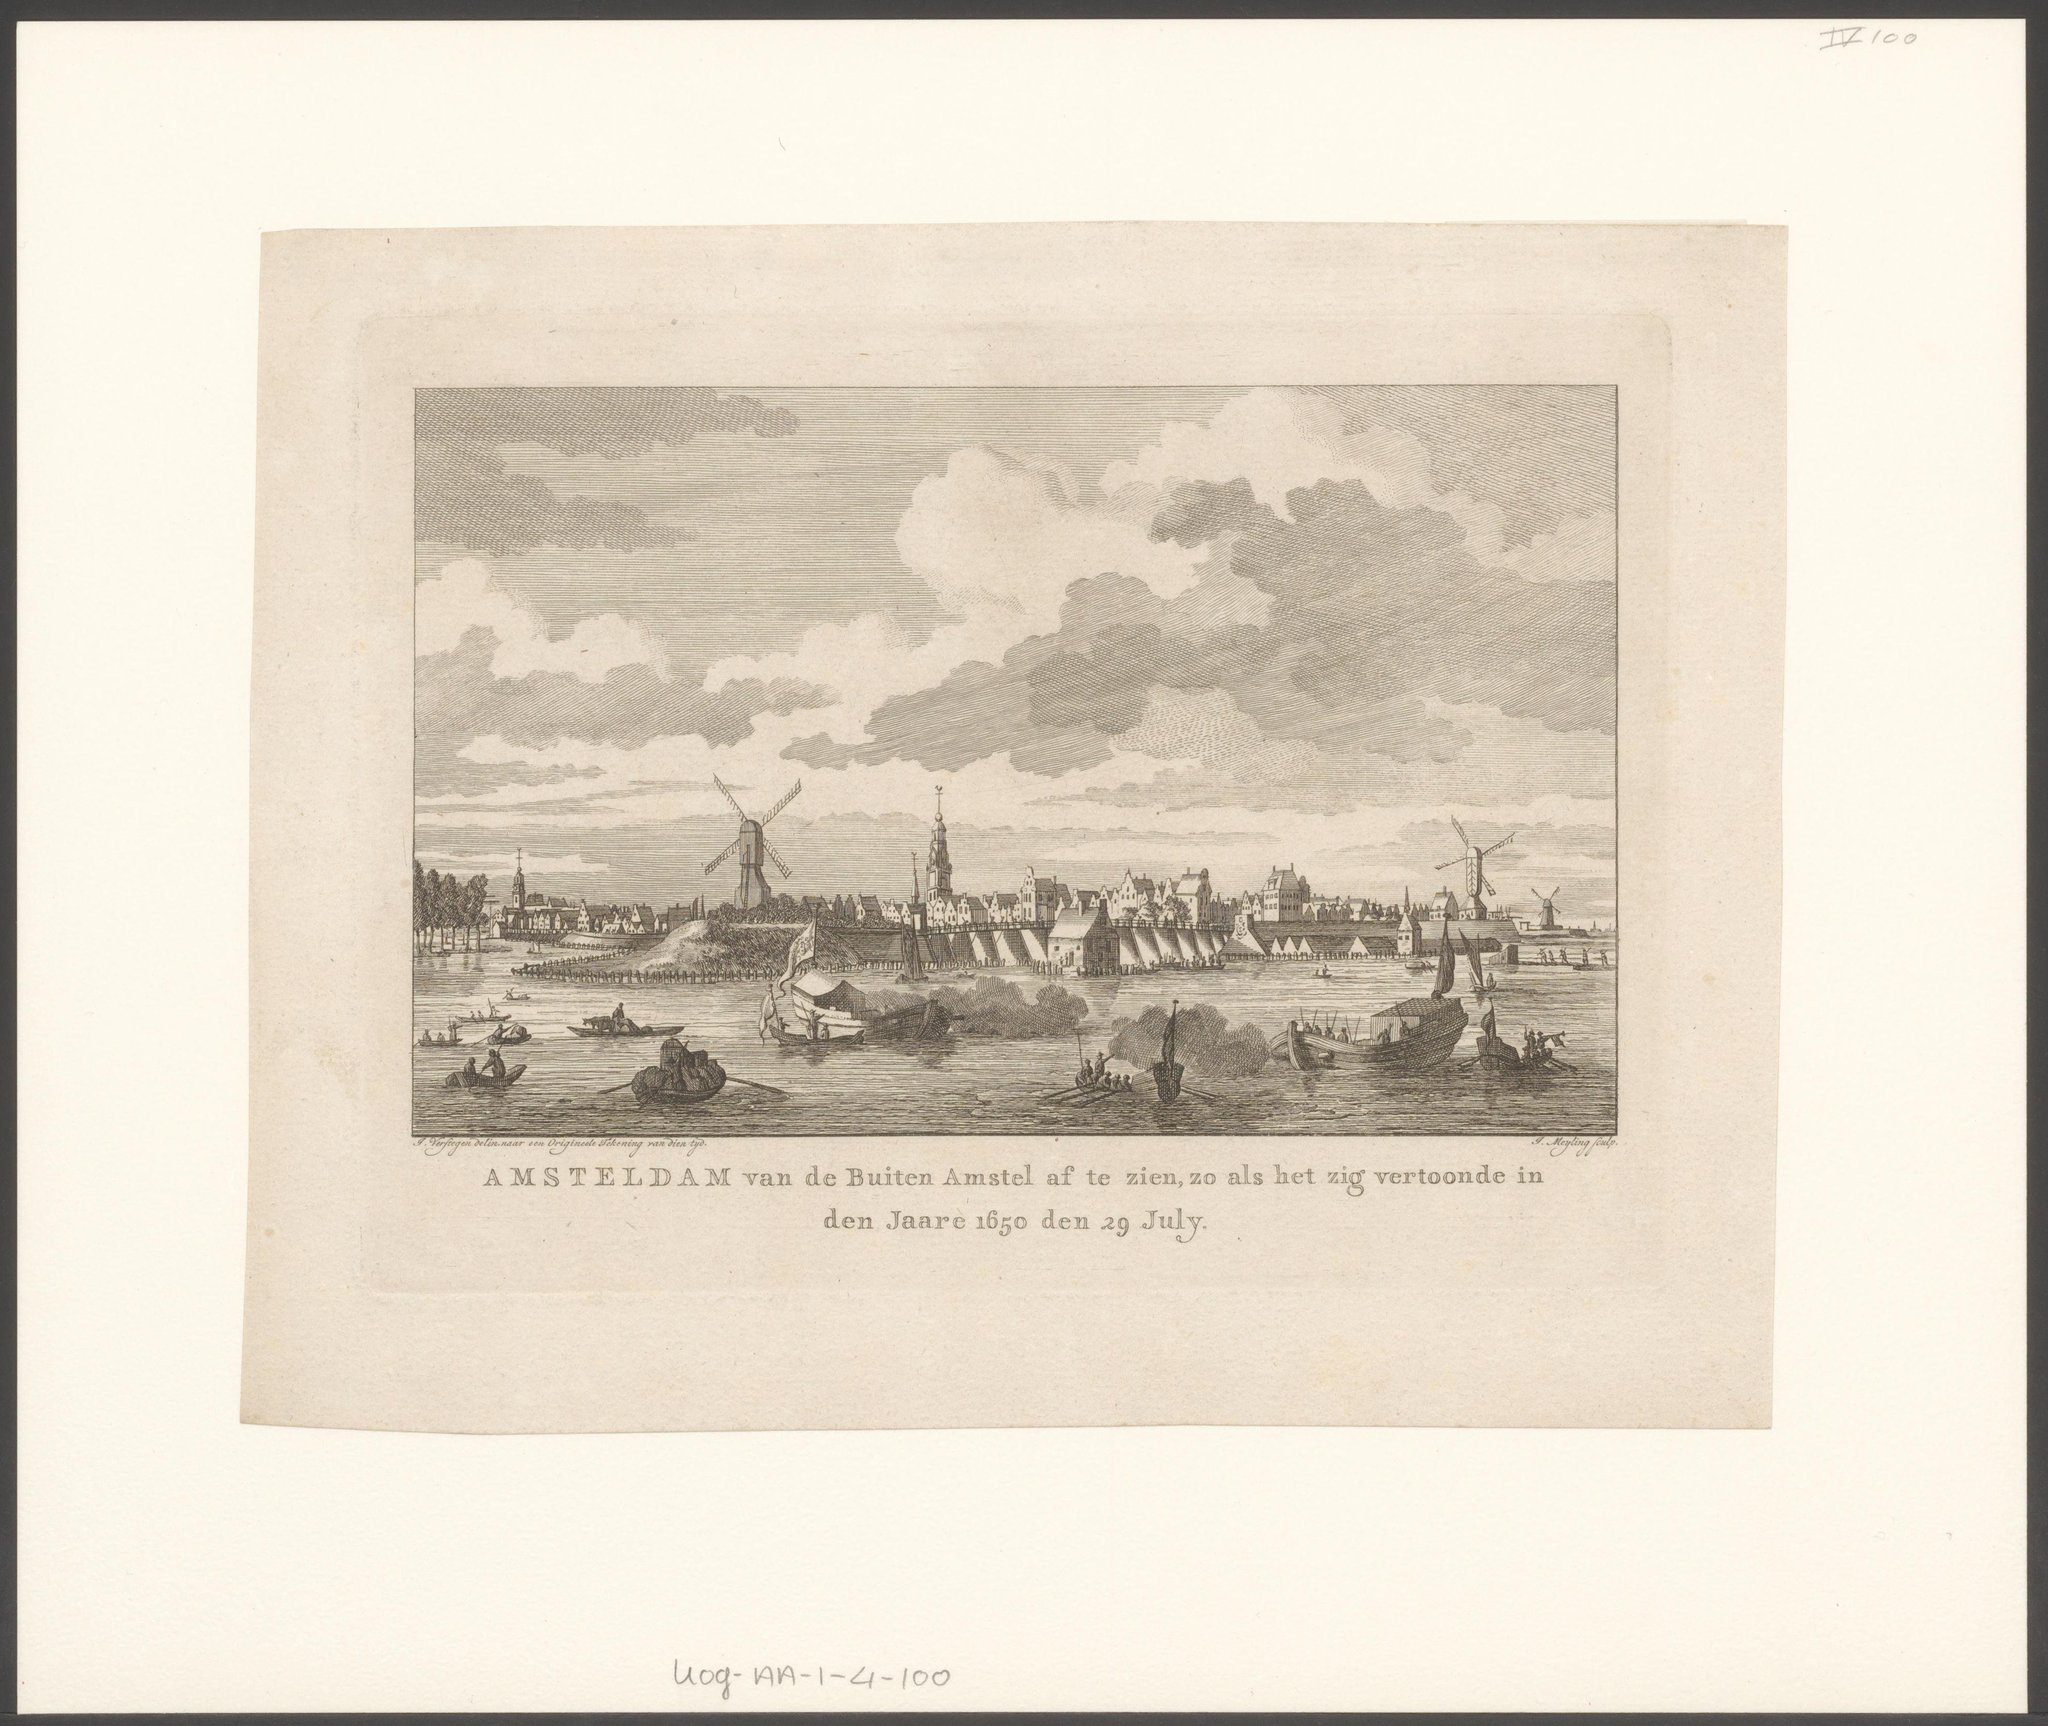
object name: print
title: Gezicht op Amsterdam vanaf de Amstel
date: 1750-1800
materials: paper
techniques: engraving, etching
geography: amsterdam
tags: city-view in general; 'veduta', river, windmill in landscape, boat propelled by man or animal, amsterdam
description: Onderwerpsrubriek binnen de Atlas Amsterdam: Amstel van Hogesluis stroomopwaarts.